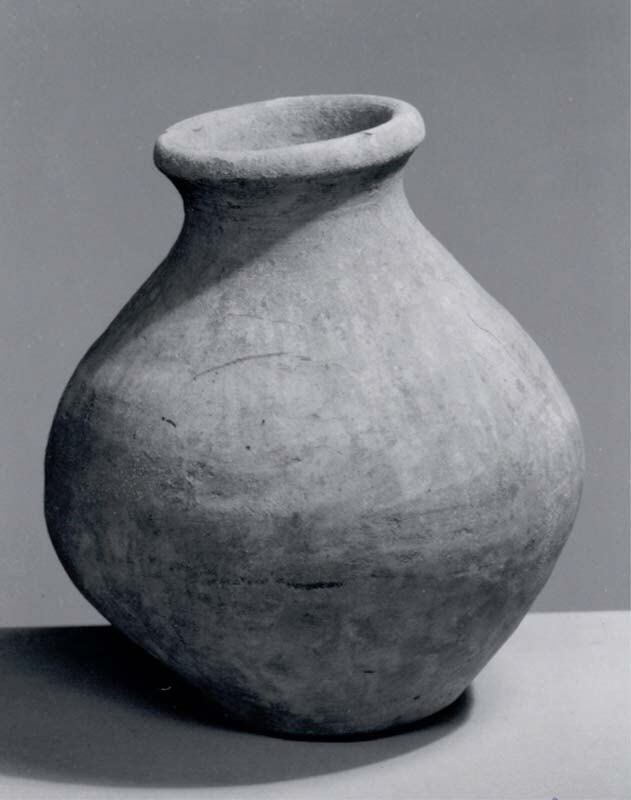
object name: jar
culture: iranian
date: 900-801 BCE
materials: ceramic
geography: iran